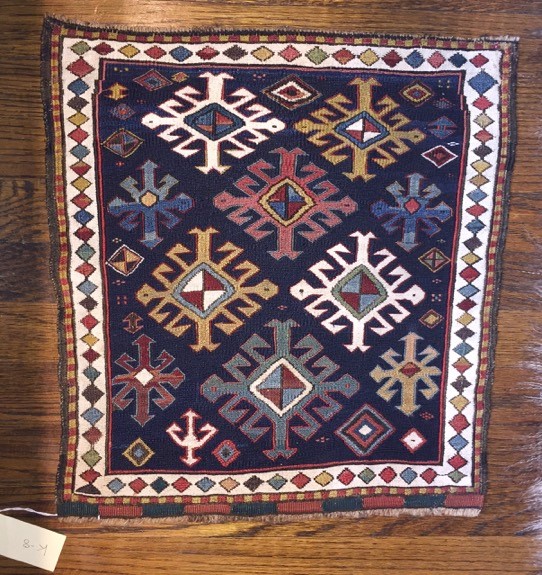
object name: saddle bag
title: Shahsevan Saddle Bag Face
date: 1870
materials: cotton, wool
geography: iran